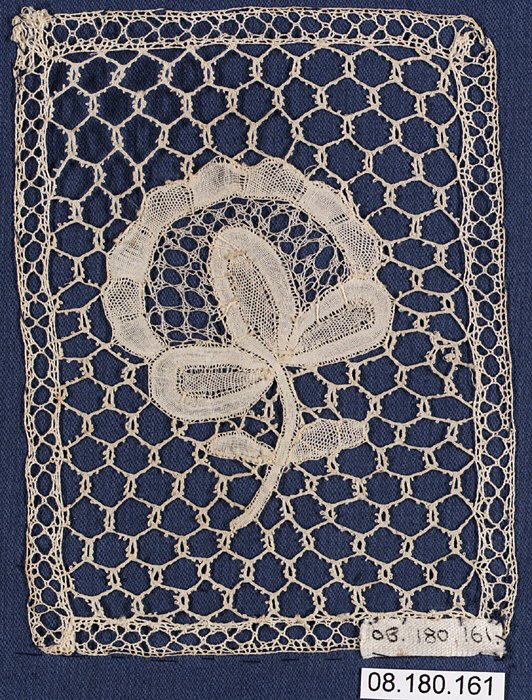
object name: square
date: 1801-1833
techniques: lace